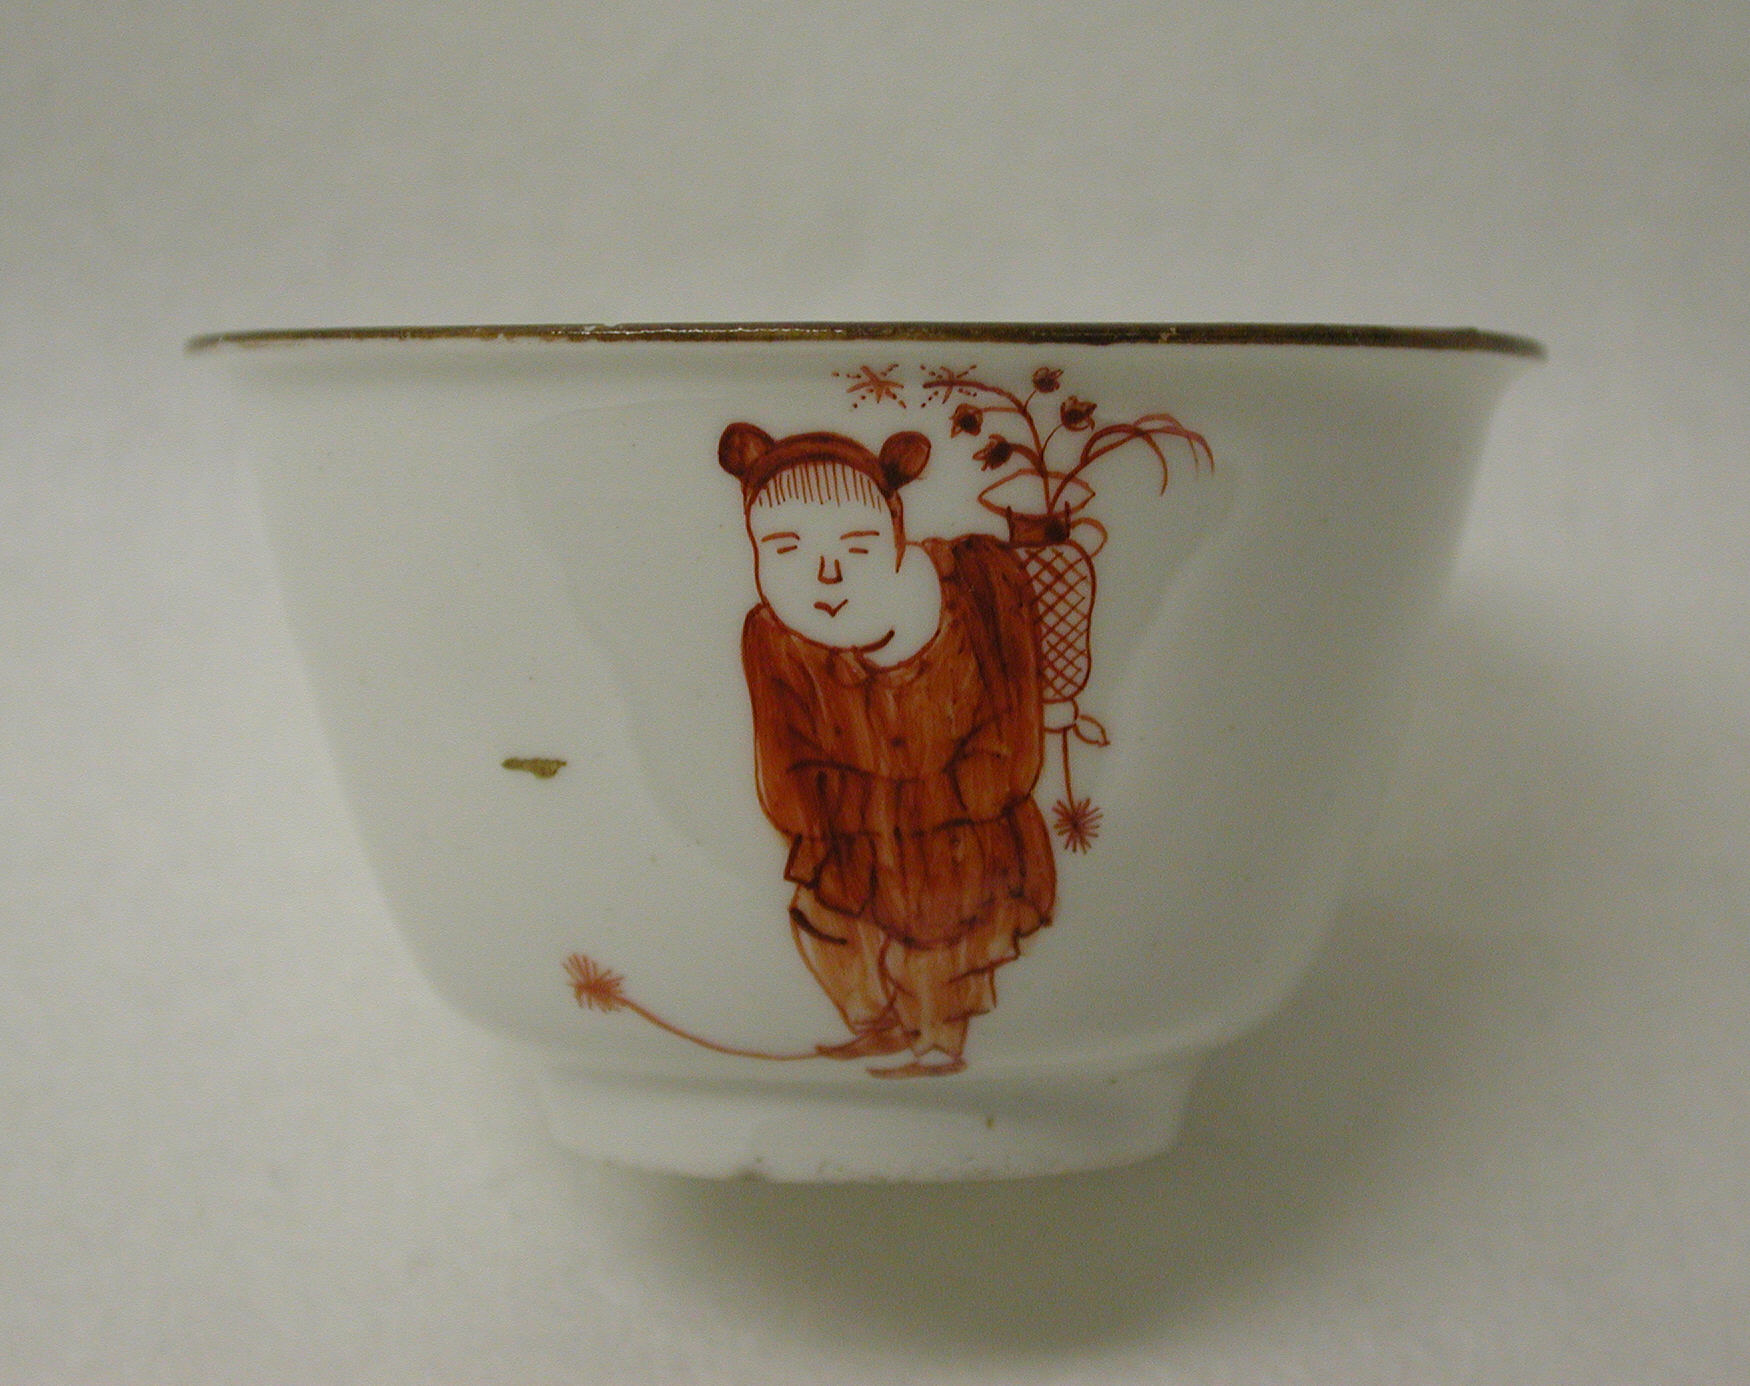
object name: teabowl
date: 1701-1900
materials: porcelain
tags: human figures